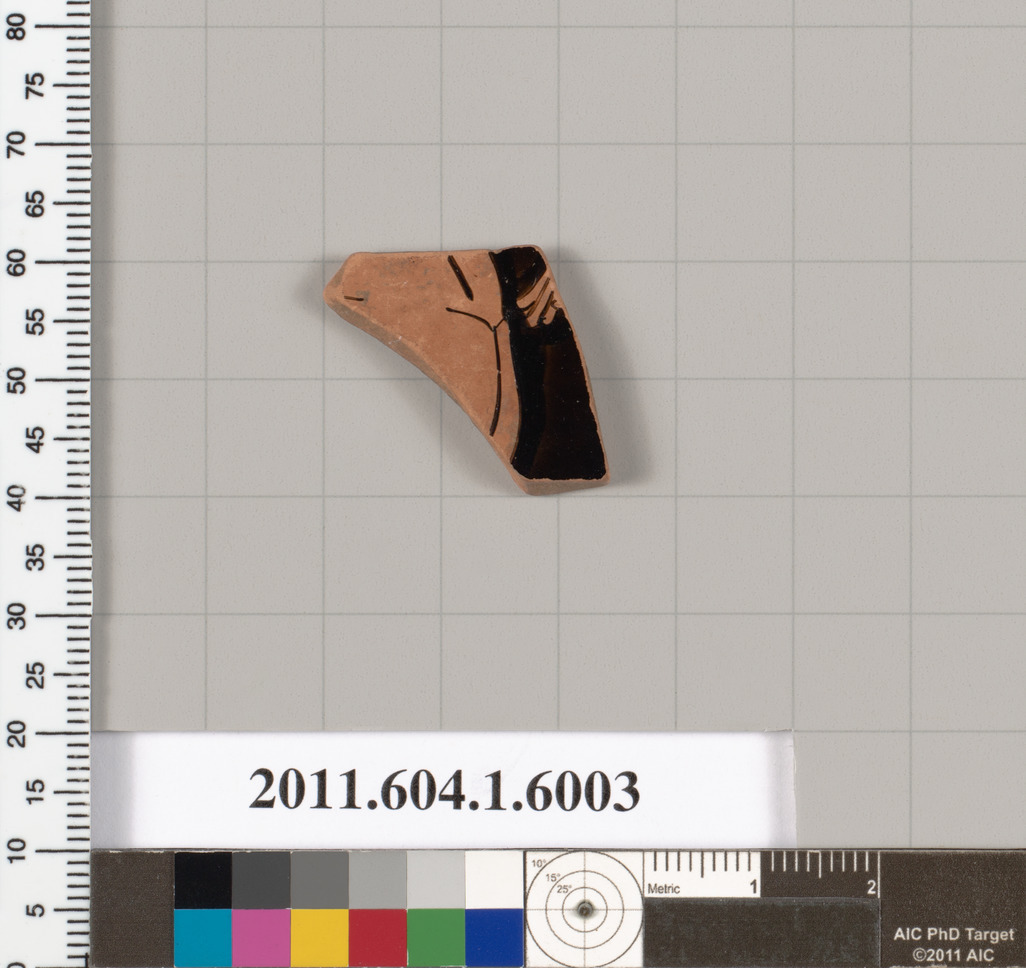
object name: kylix fragment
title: Terracotta fragment of a kylix (drinking cup)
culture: greek, attic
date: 510-500 BCE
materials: terracotta